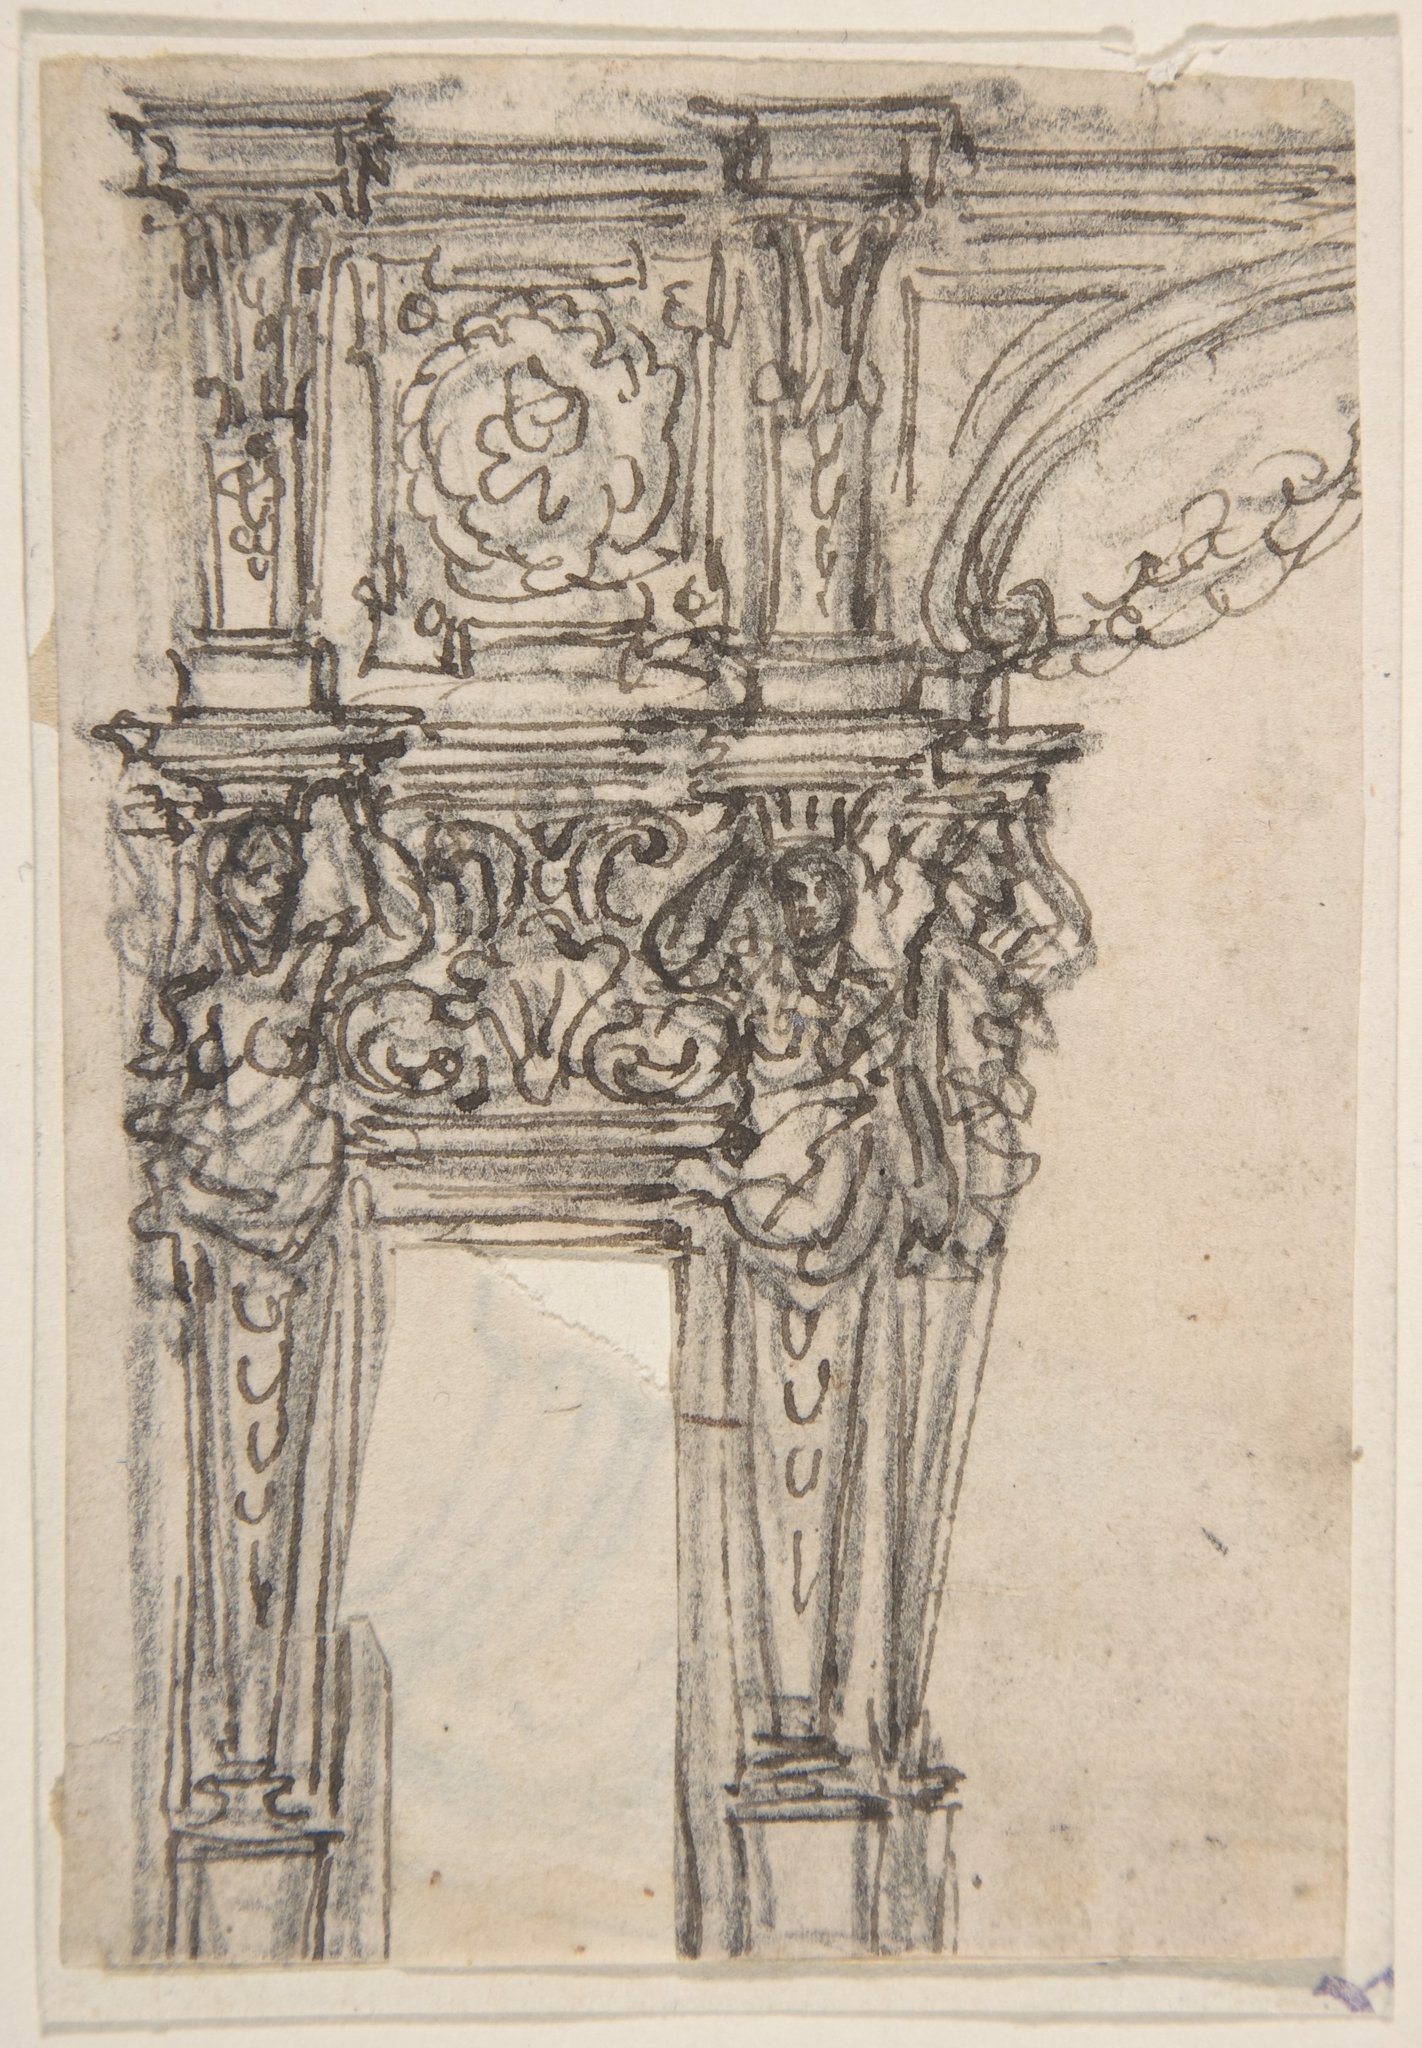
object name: drawing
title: Design for a Proscenium or Monumental Alcove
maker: giovanni battista foggini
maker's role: artist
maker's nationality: italian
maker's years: 1652-1725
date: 1672-1725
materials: chalk, ink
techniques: pen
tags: caryatids